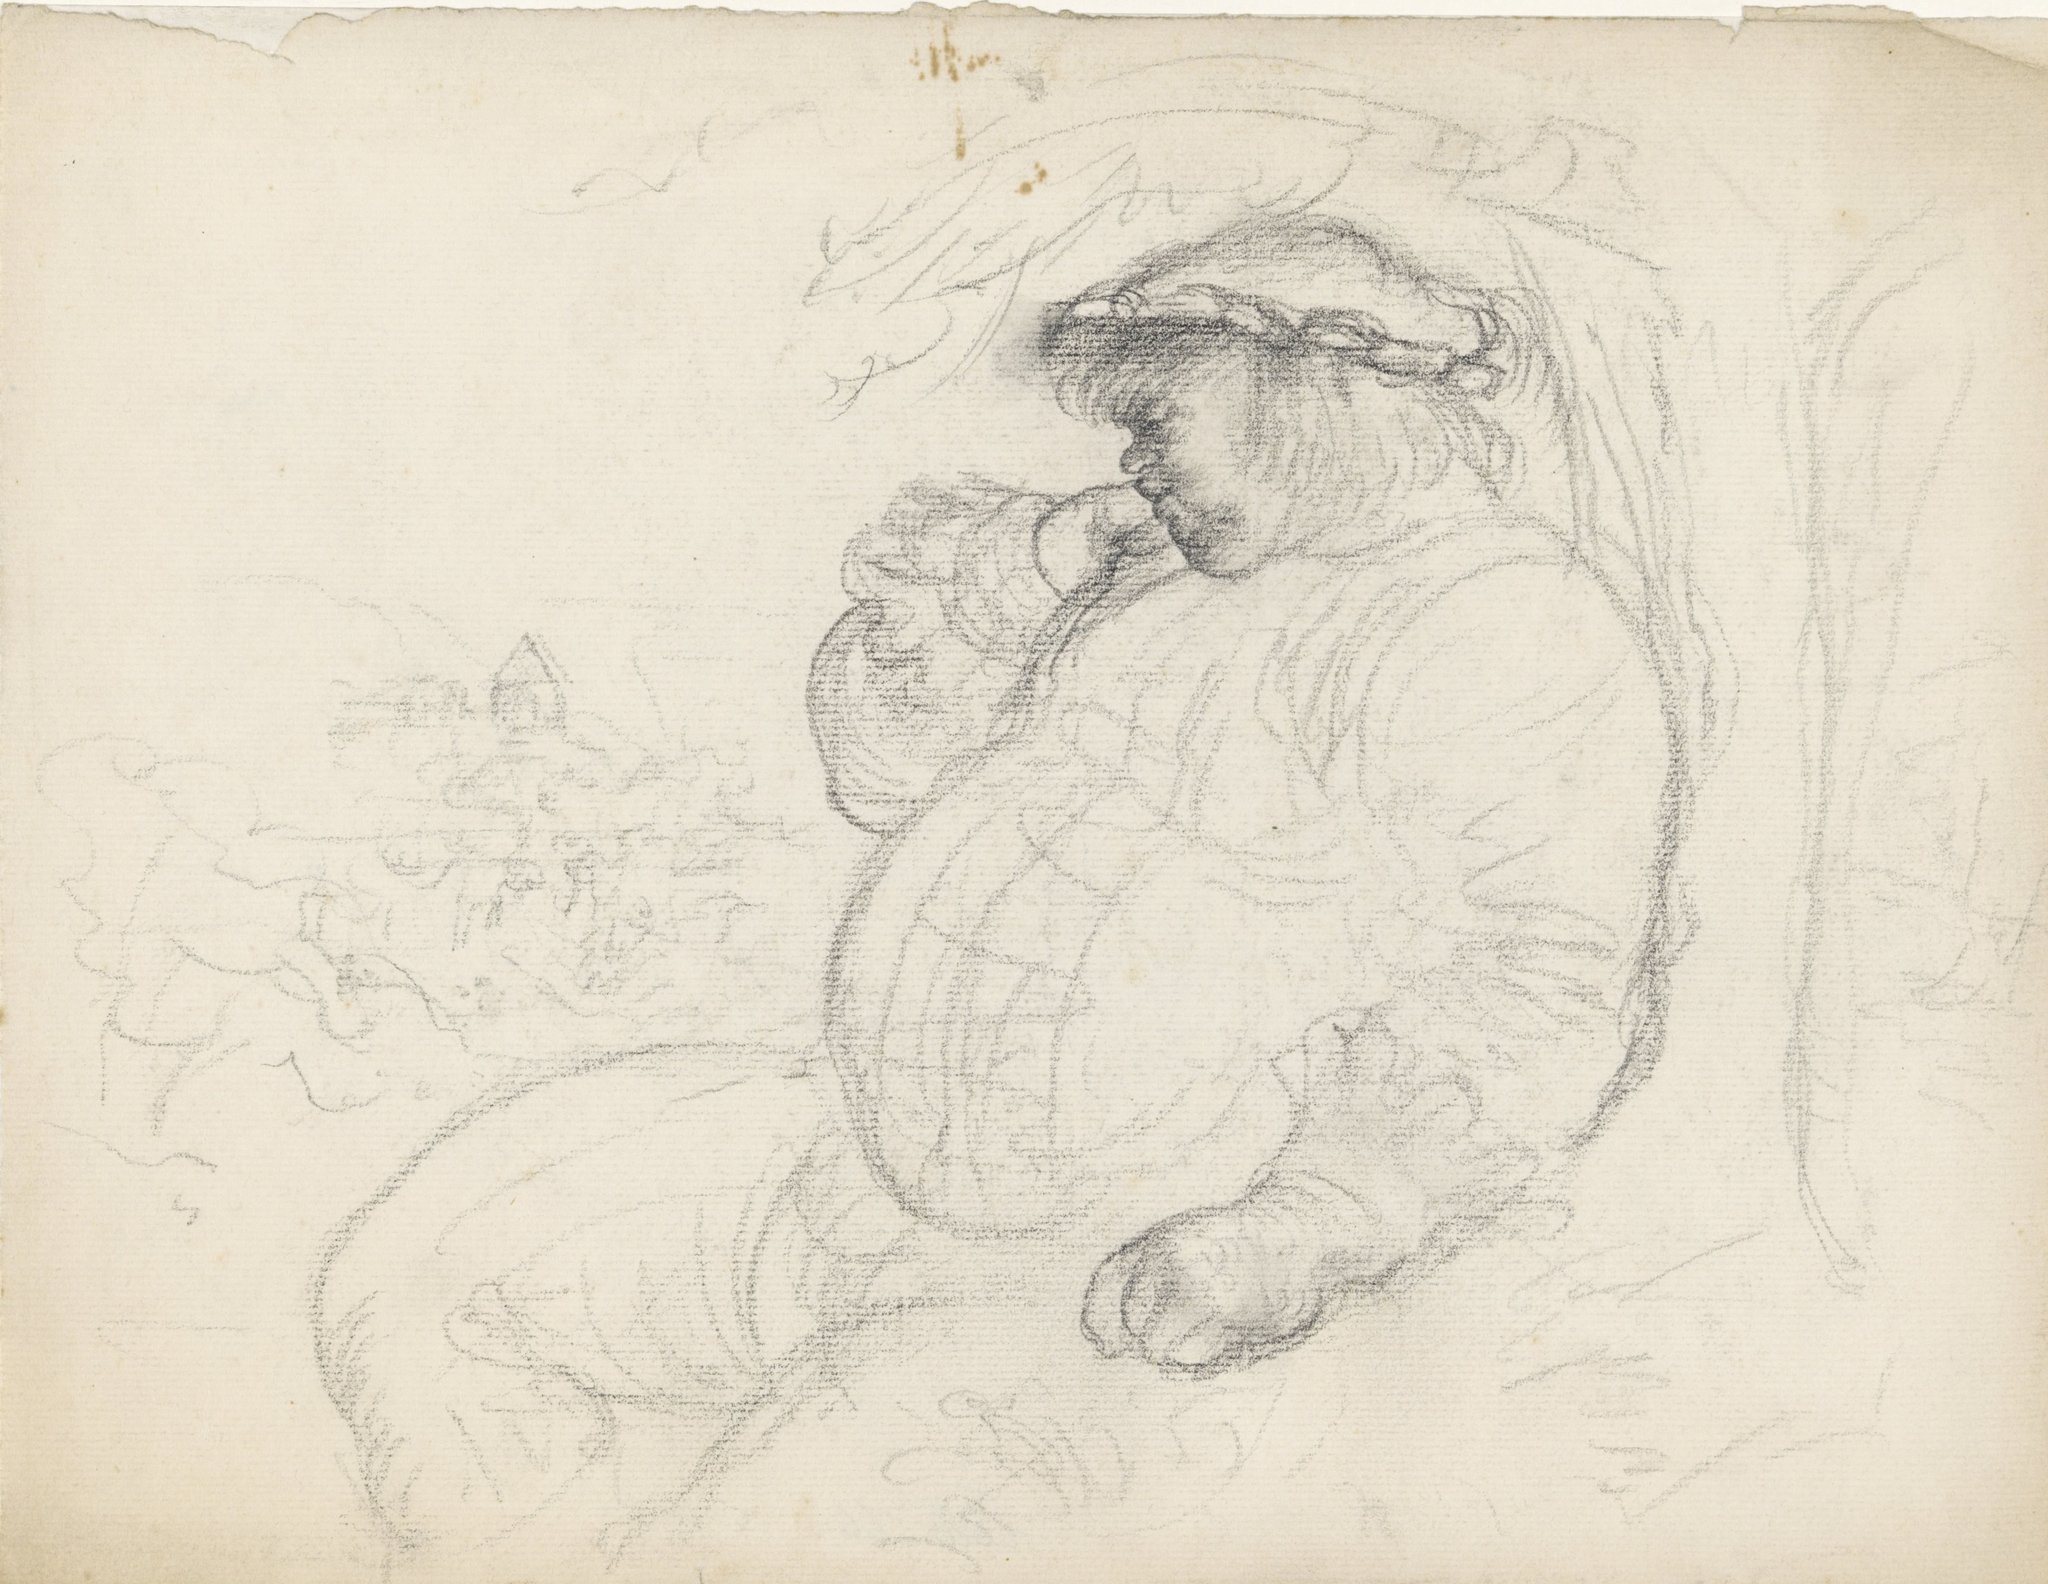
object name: drawing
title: Reus zittend onder een boom uitkijkend over een landschap met bomen en huizen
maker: henk henriët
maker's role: draughtsman, print maker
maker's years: 1903-1945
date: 1936-1940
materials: paper, pencil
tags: trees, landscapes, giants, colossi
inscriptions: collector's mark: Lugt 2228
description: Deze tekening is mogelijk een ontwerp voor een illustratie bij het boek 'Gargantua en Pantagruel' van François Rabelais.